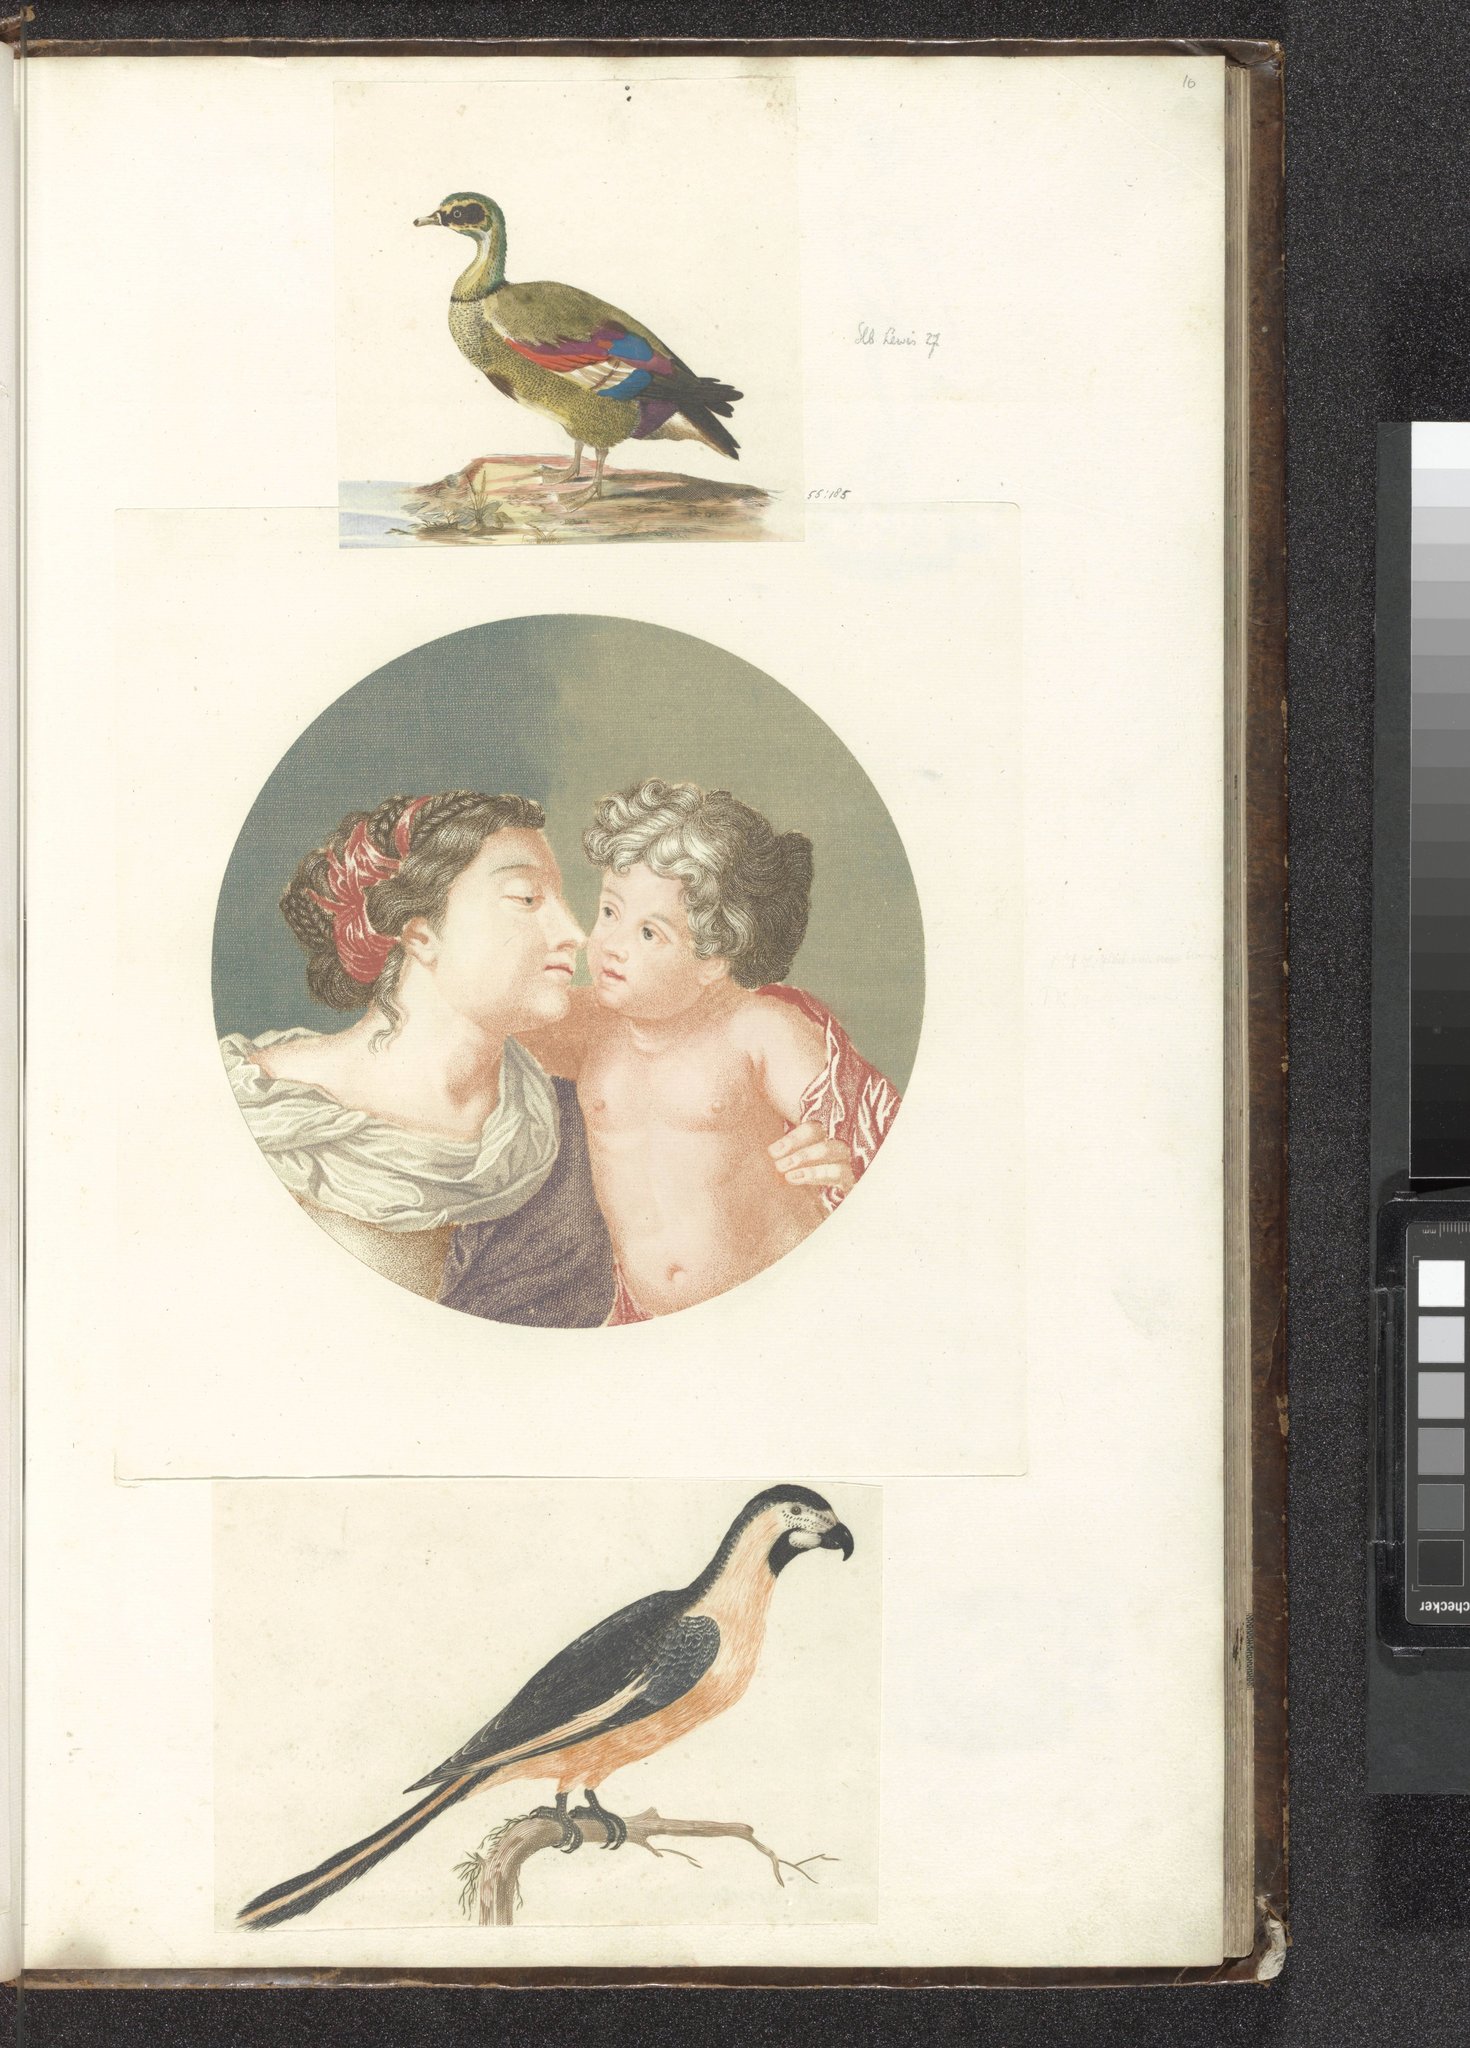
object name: print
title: Moeder en kind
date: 1688-1698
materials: paper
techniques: etching, lithography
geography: netherlands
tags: madonna: i.e. mary with the christ-child, mother and baby or young child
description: Een moeder met een kind op de arm in medaillon. Mogelijk Maria met Christuskind. Deze prent maakt deel uit van een album.